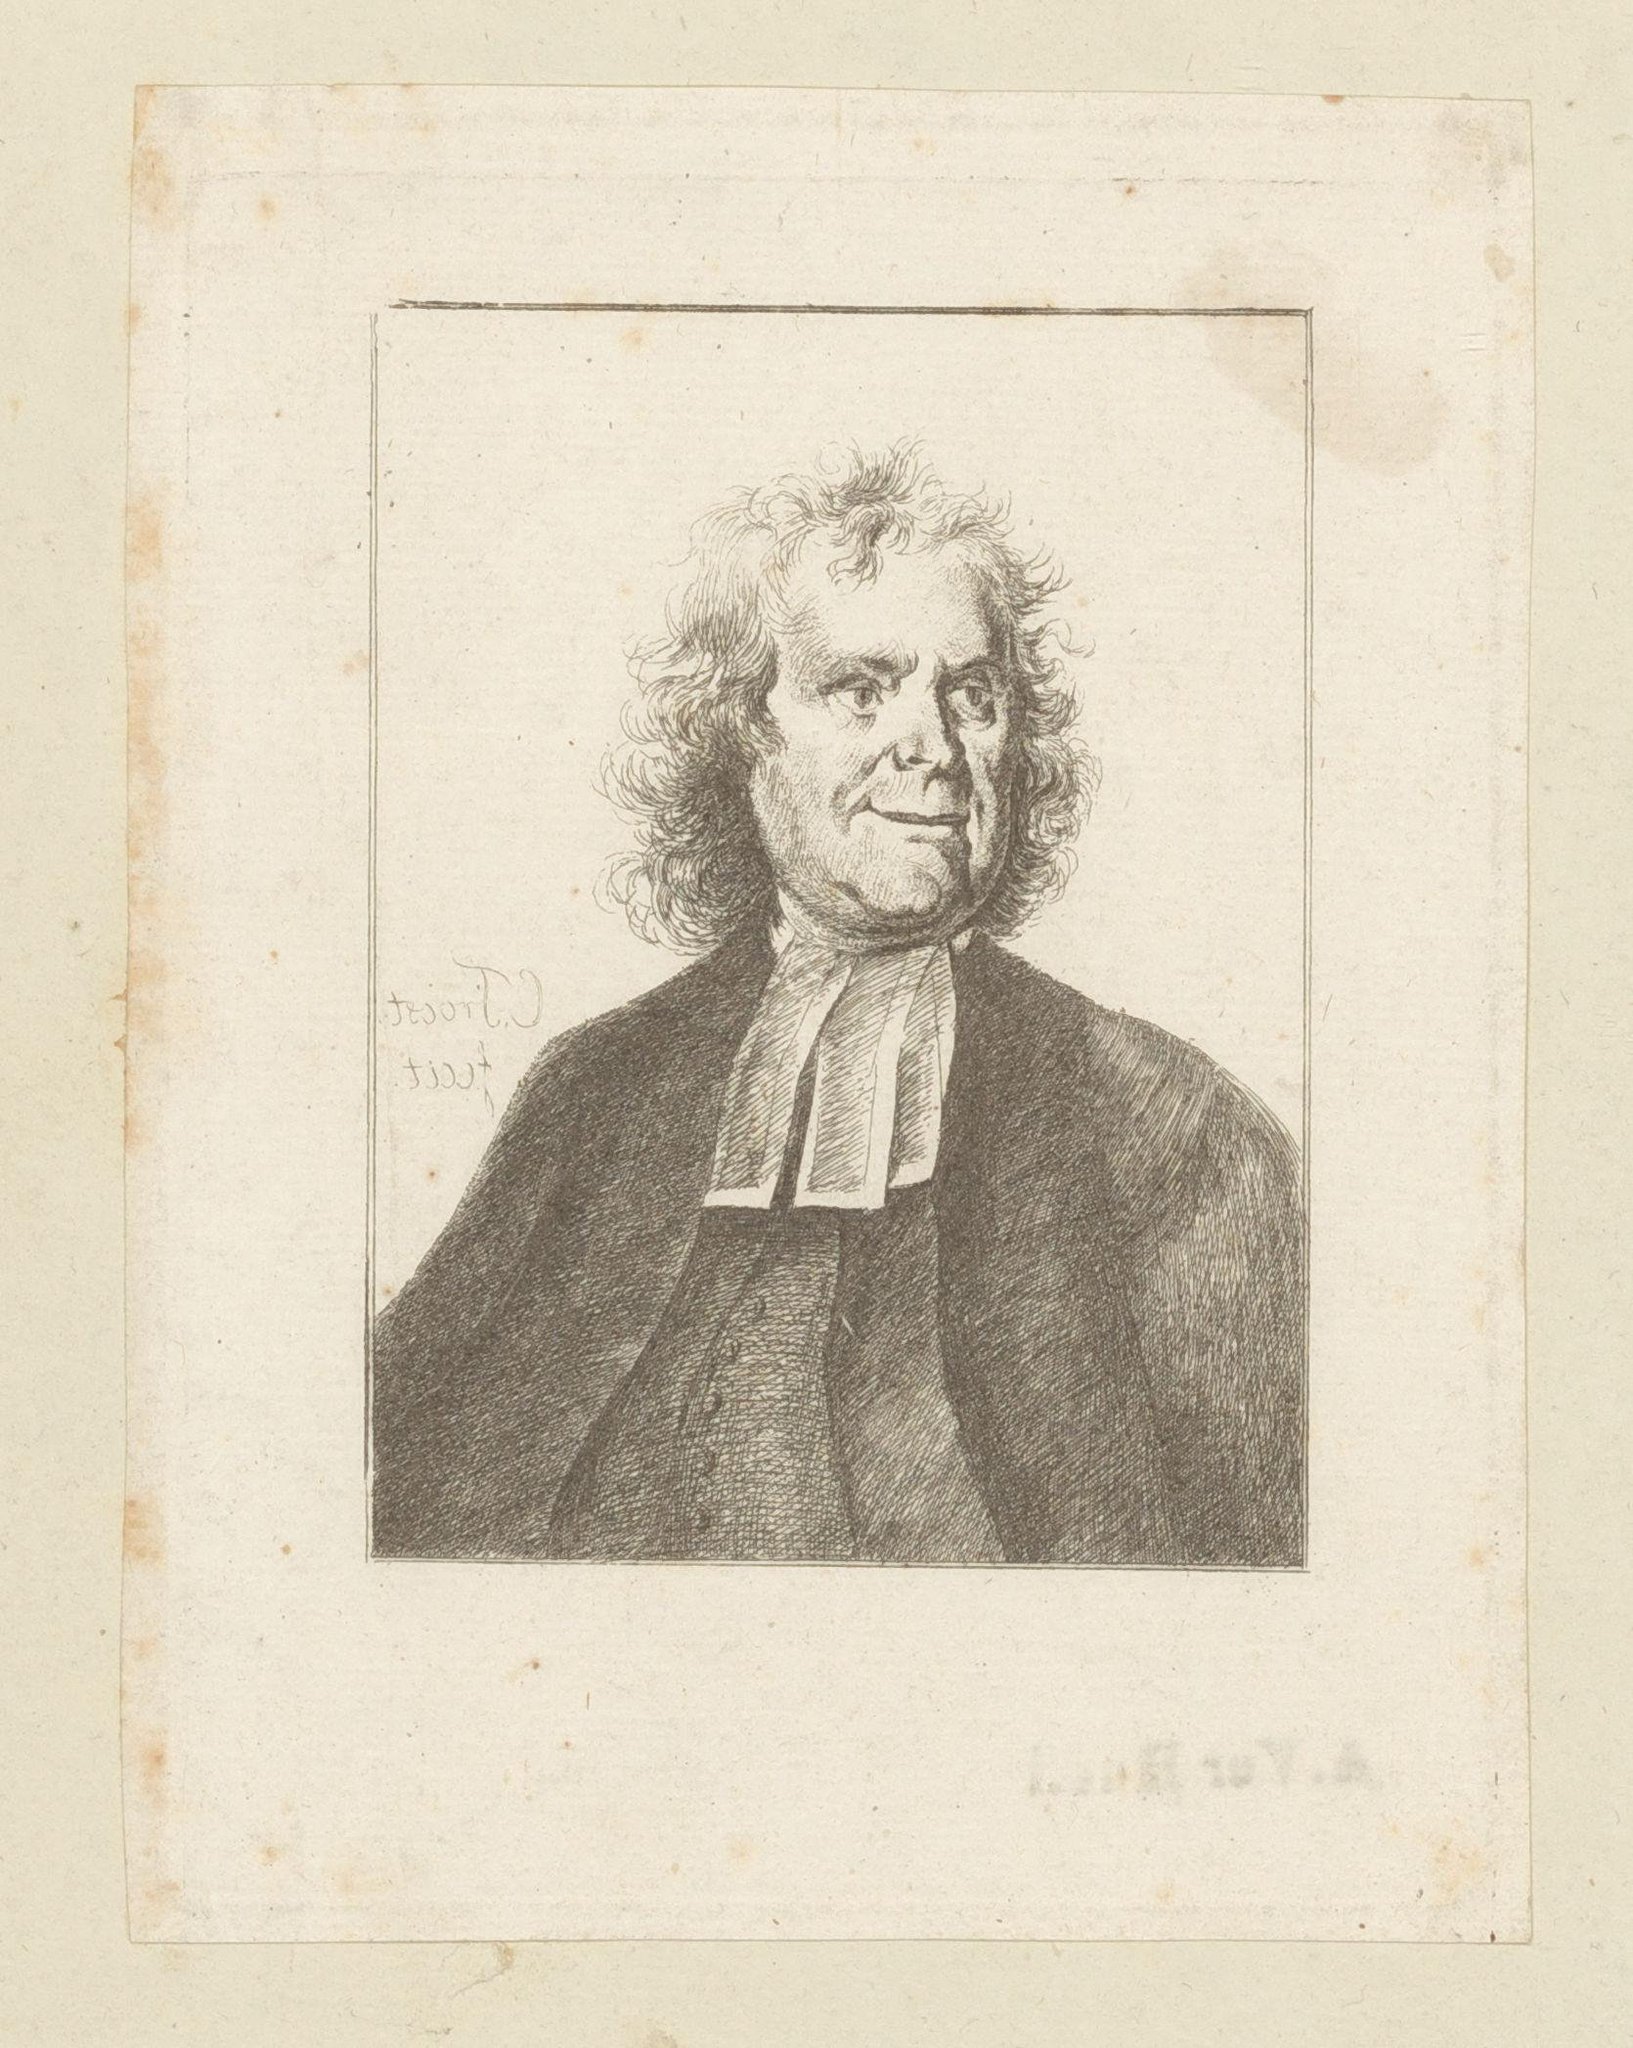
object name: print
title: Portret van Hermanus Boerhaave (versie B)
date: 1762-1782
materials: paper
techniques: printmaking, etching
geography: the hague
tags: hermanus boerhaave, historical persons, physician, doctor (+ scholar, scientist (at work))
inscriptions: collector's mark: Lugt 2488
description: Portret van Hermanus Boerhaave, buste, driekwart naar rechts. Tegendruk van de versie B van het portret, door Heenck. Samen met drie andere versies van deze prent opgezet op een blad met een handschrift met de anekdote over het aan stukken snijden van de koperplaat door de dochter van Boerhaave.